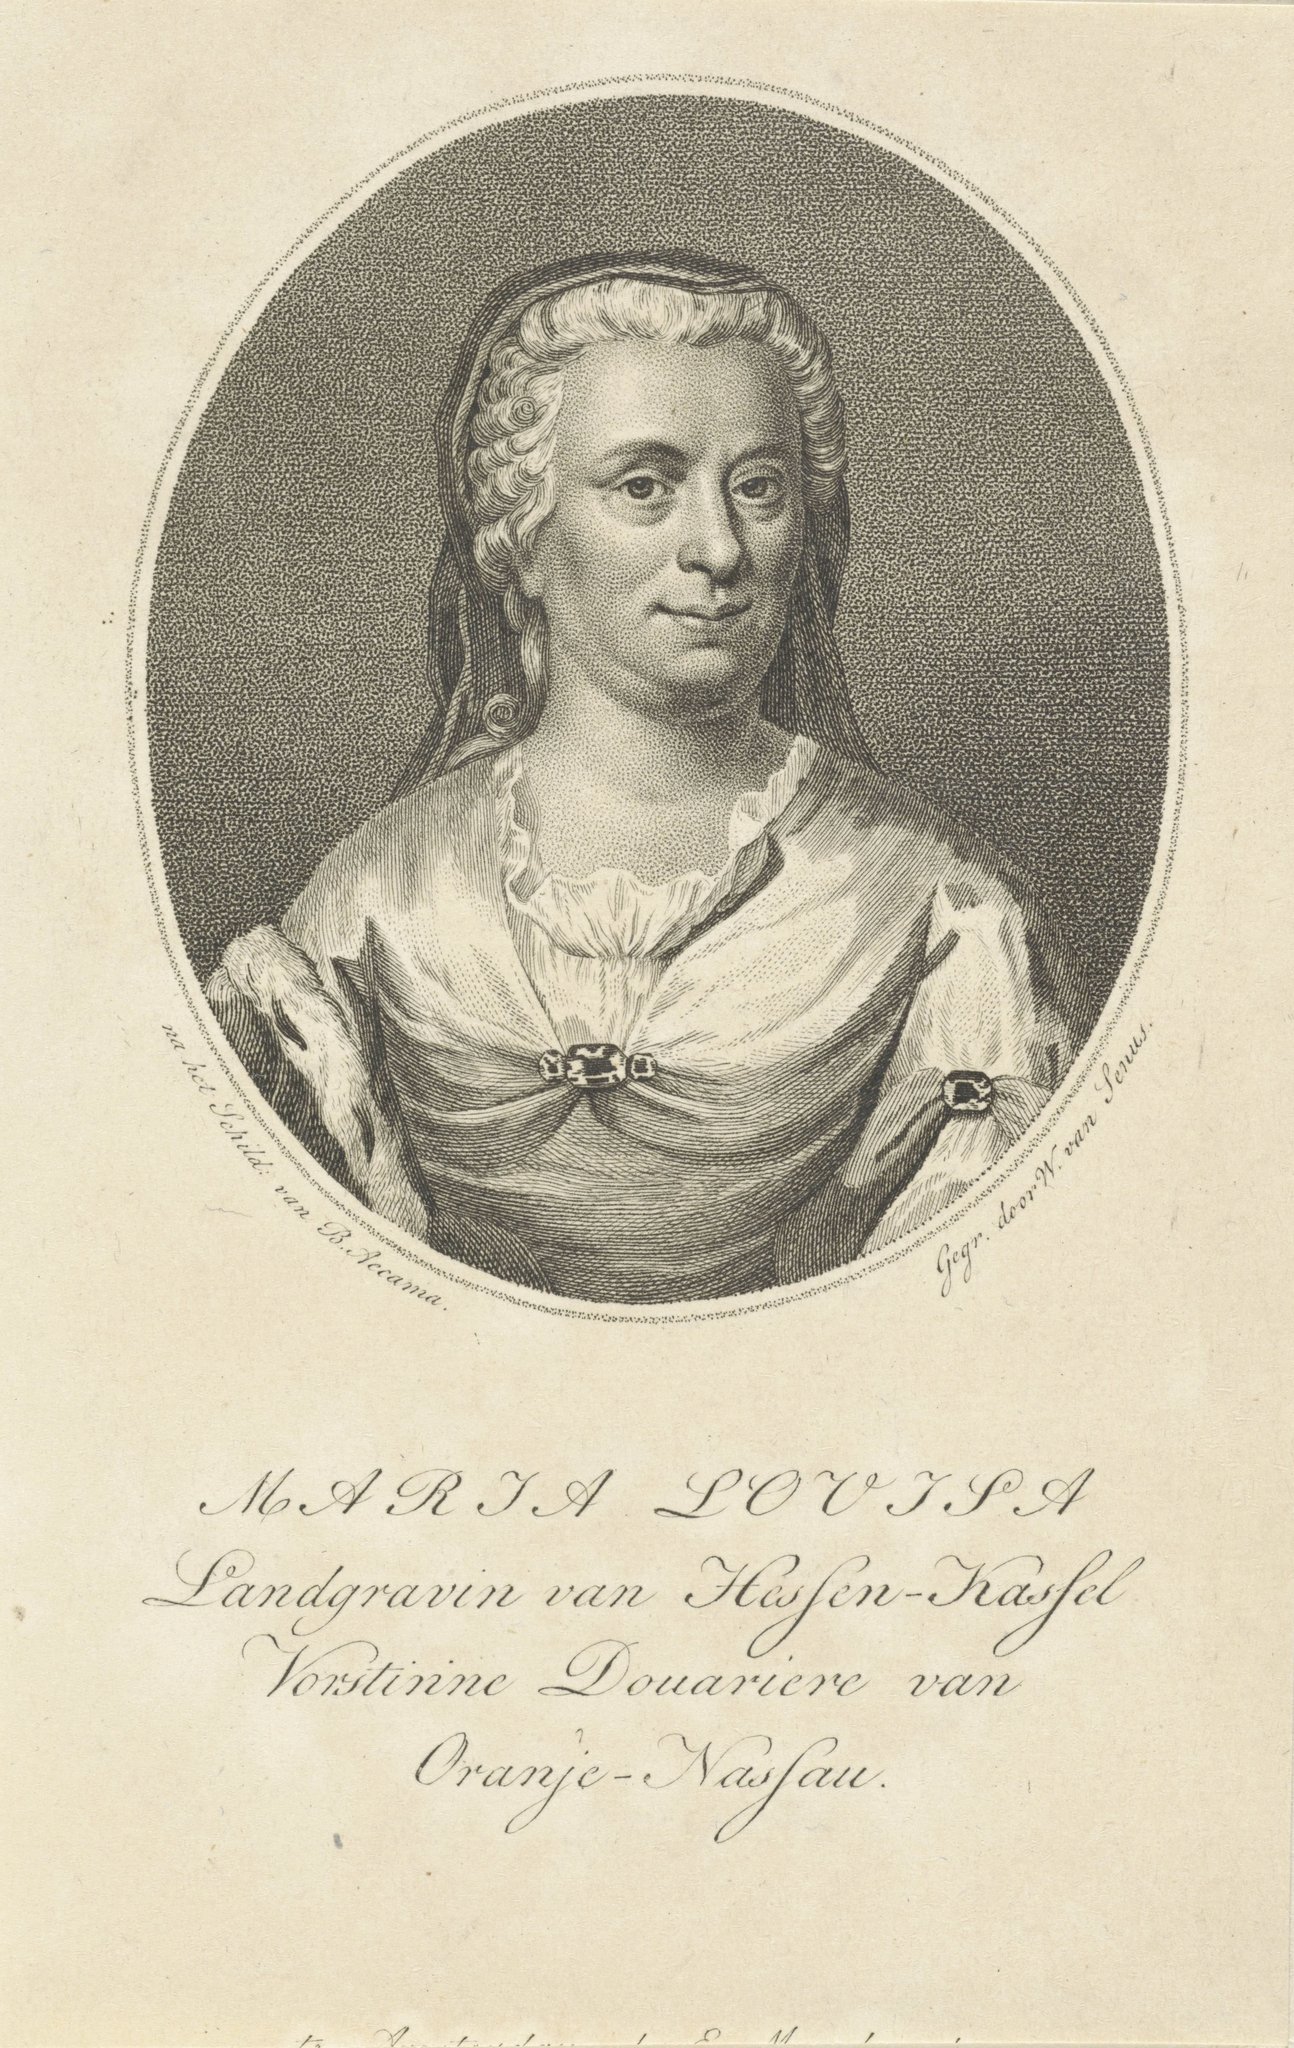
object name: print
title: Portret van Maria Louisa van Hessen-Kassel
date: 1787-1834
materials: paper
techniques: engraving, etching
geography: amsterdam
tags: kassel, leeuwarden, maria louisa van hessen-kassel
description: Portret van Maria Louisa in een ovaal. In de ondermarge haar naam en titels.